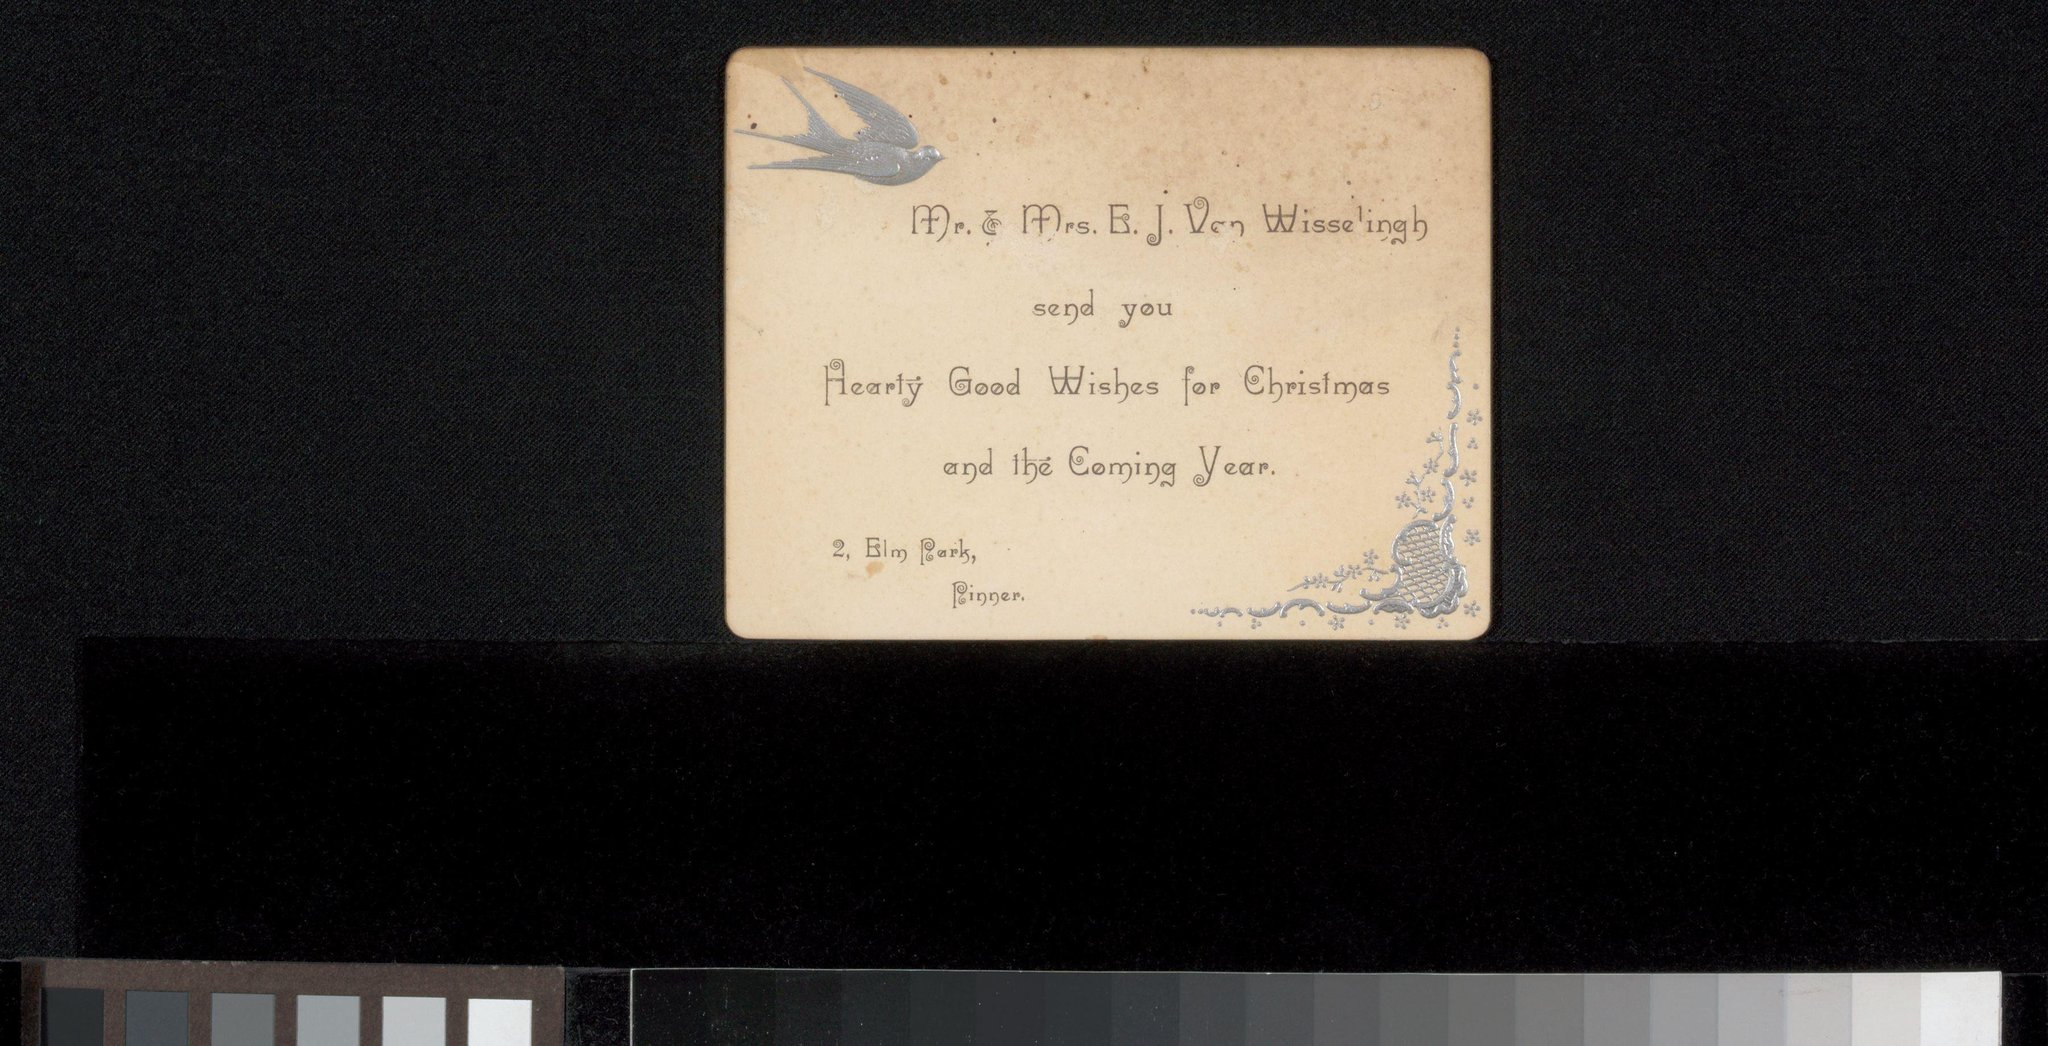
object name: letter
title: Brief aan Philip Zilcken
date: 1912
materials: cardboard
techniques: printing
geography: london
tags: the hague, draughtsman, philip zilcken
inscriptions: collector's mark: ‘RPK’